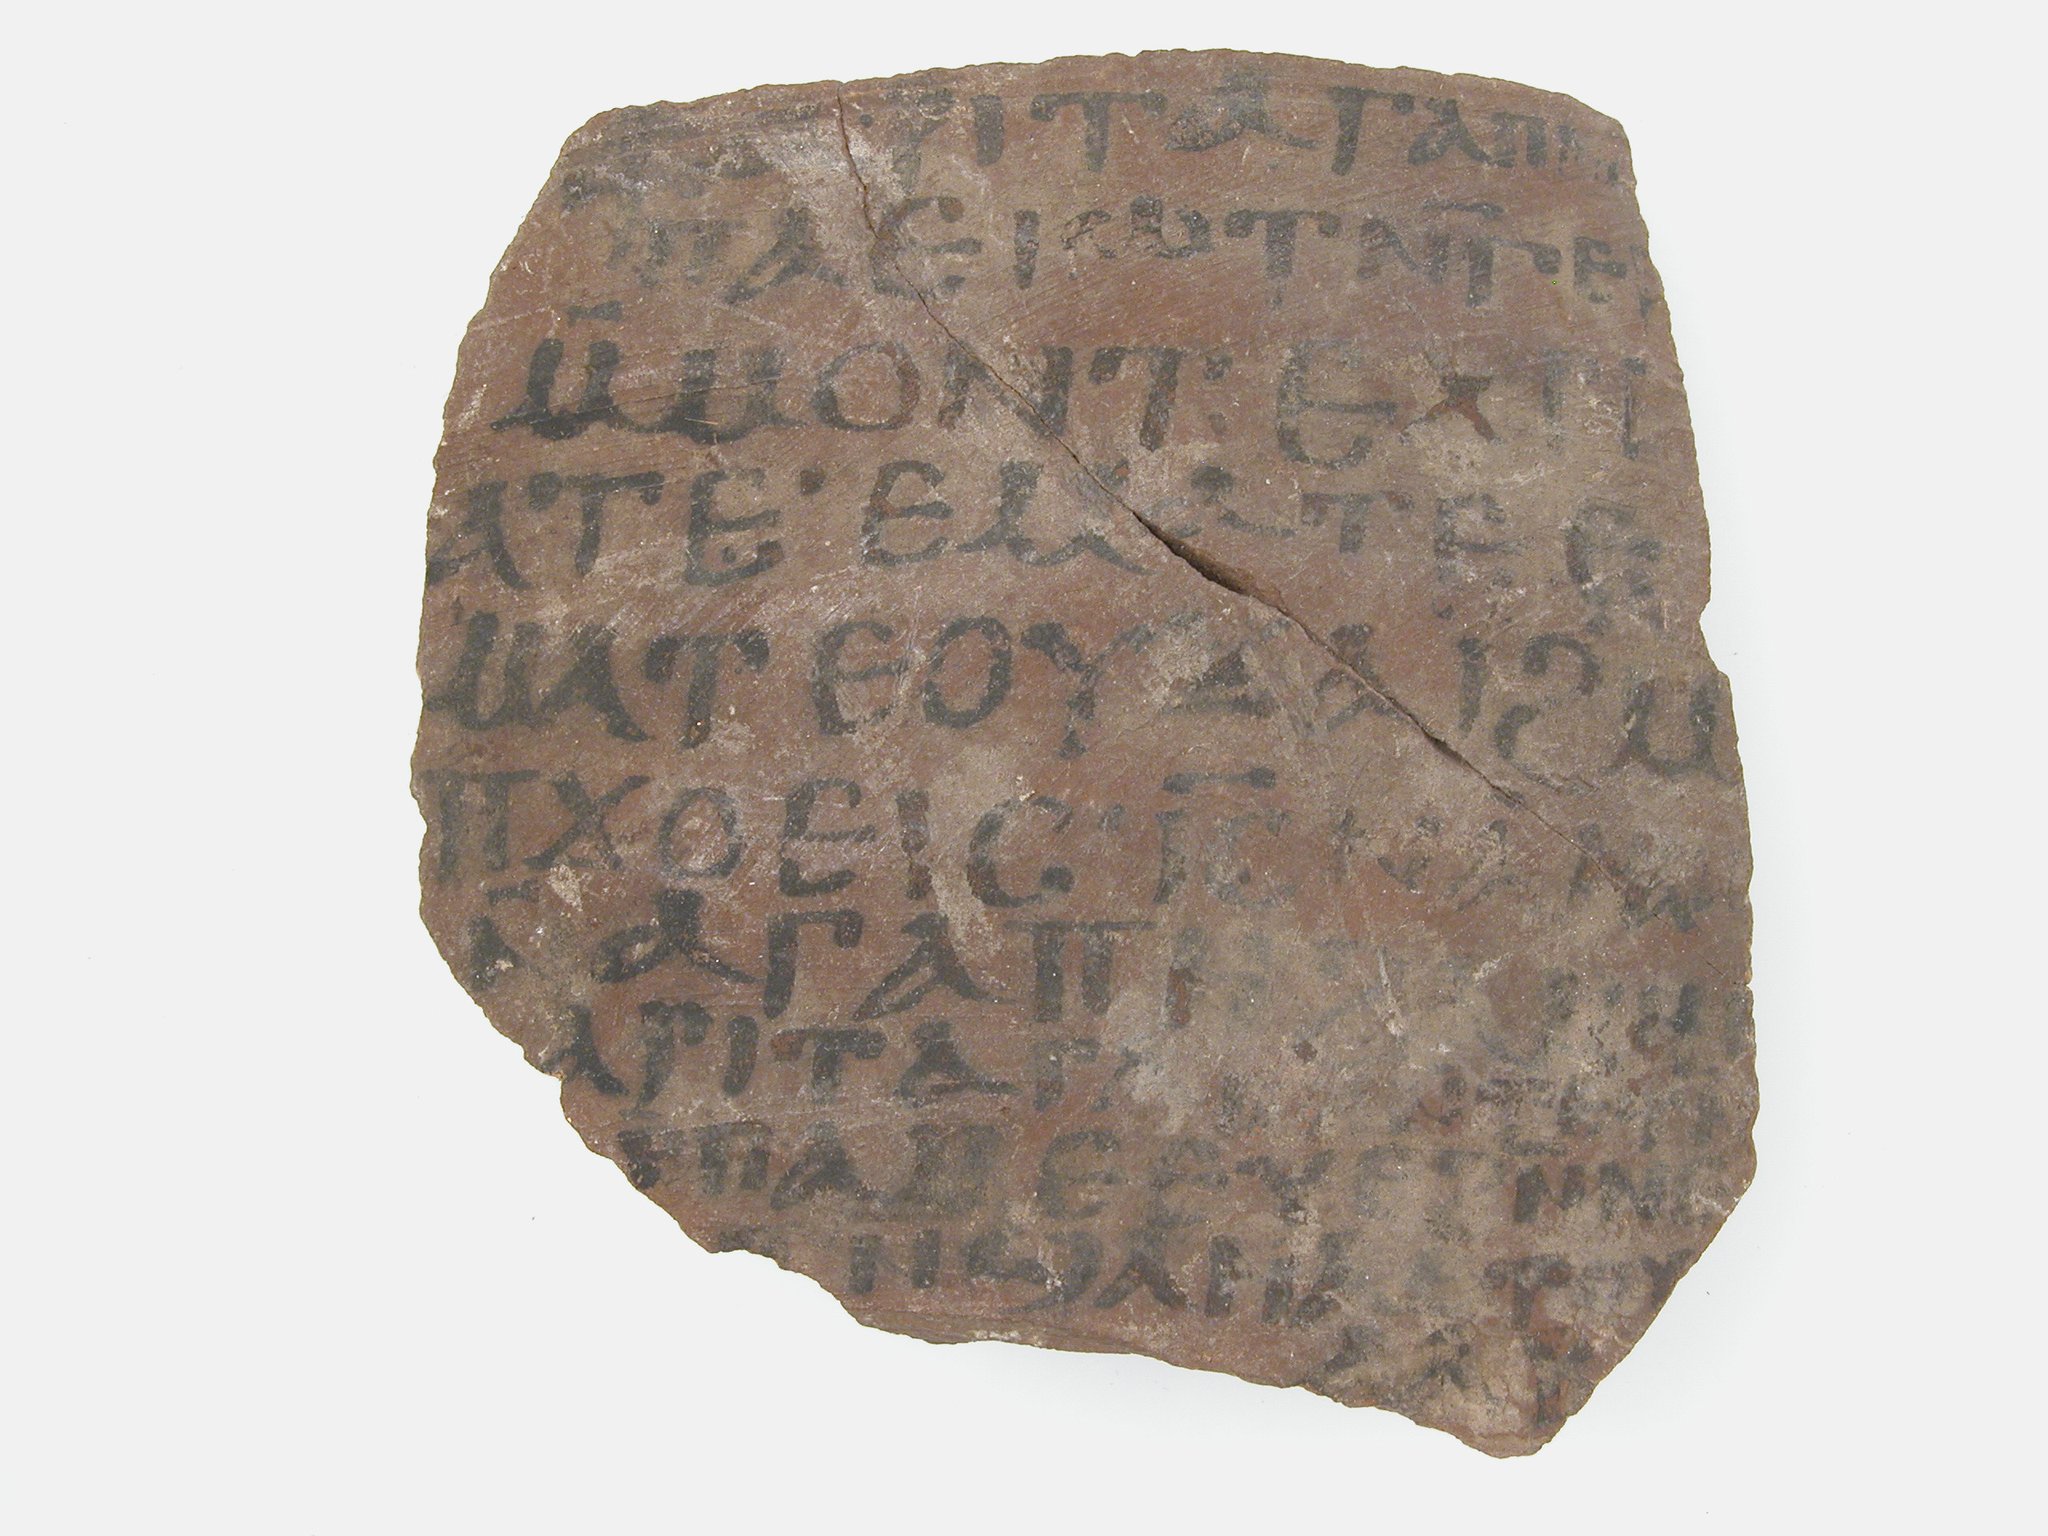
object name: ostrakon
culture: coptic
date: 600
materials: ink, pottery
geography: egypt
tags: coptic,documents